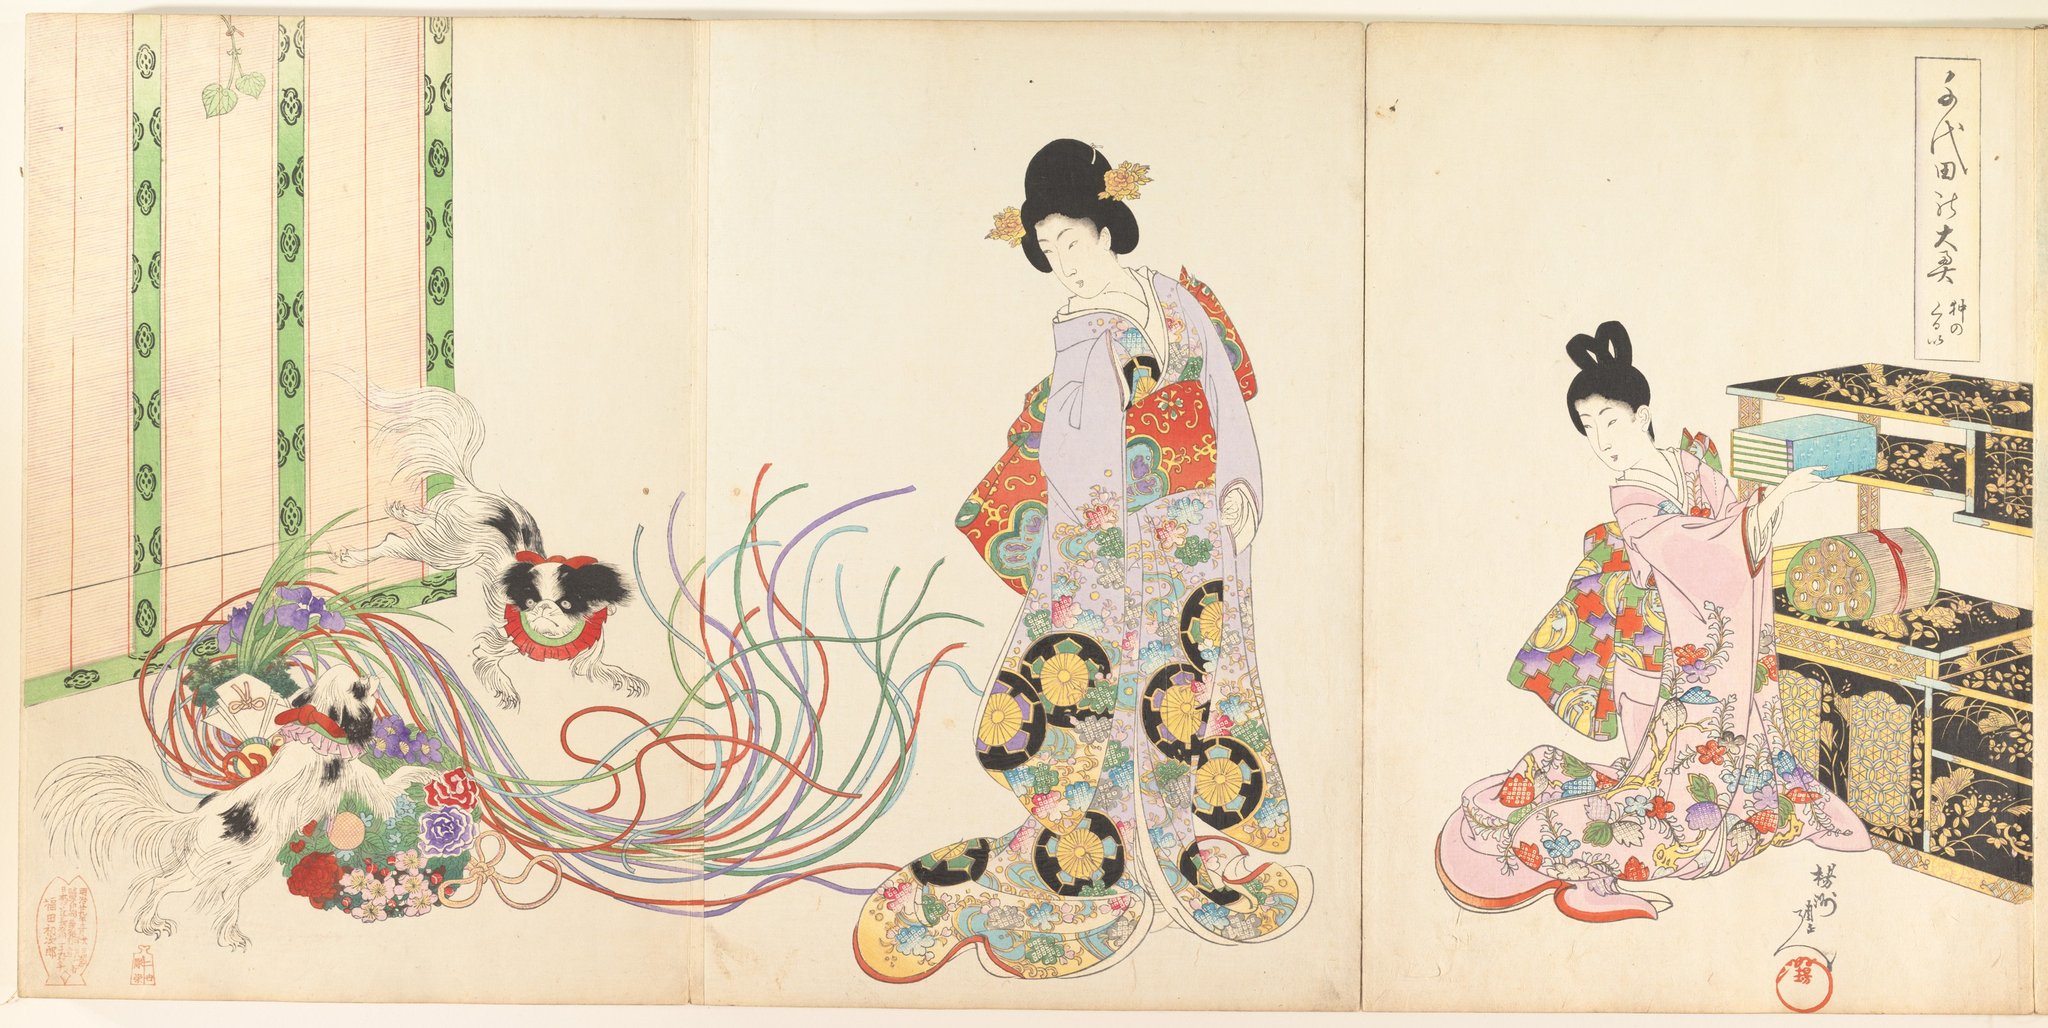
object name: print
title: Chiyoda Castle (Album of Women)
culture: japanese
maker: yōshū (hashimoto) chikanobu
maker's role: artist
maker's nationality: japanese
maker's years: 1838-1912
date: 1895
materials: ink, paper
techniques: woodblock print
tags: women,dogs